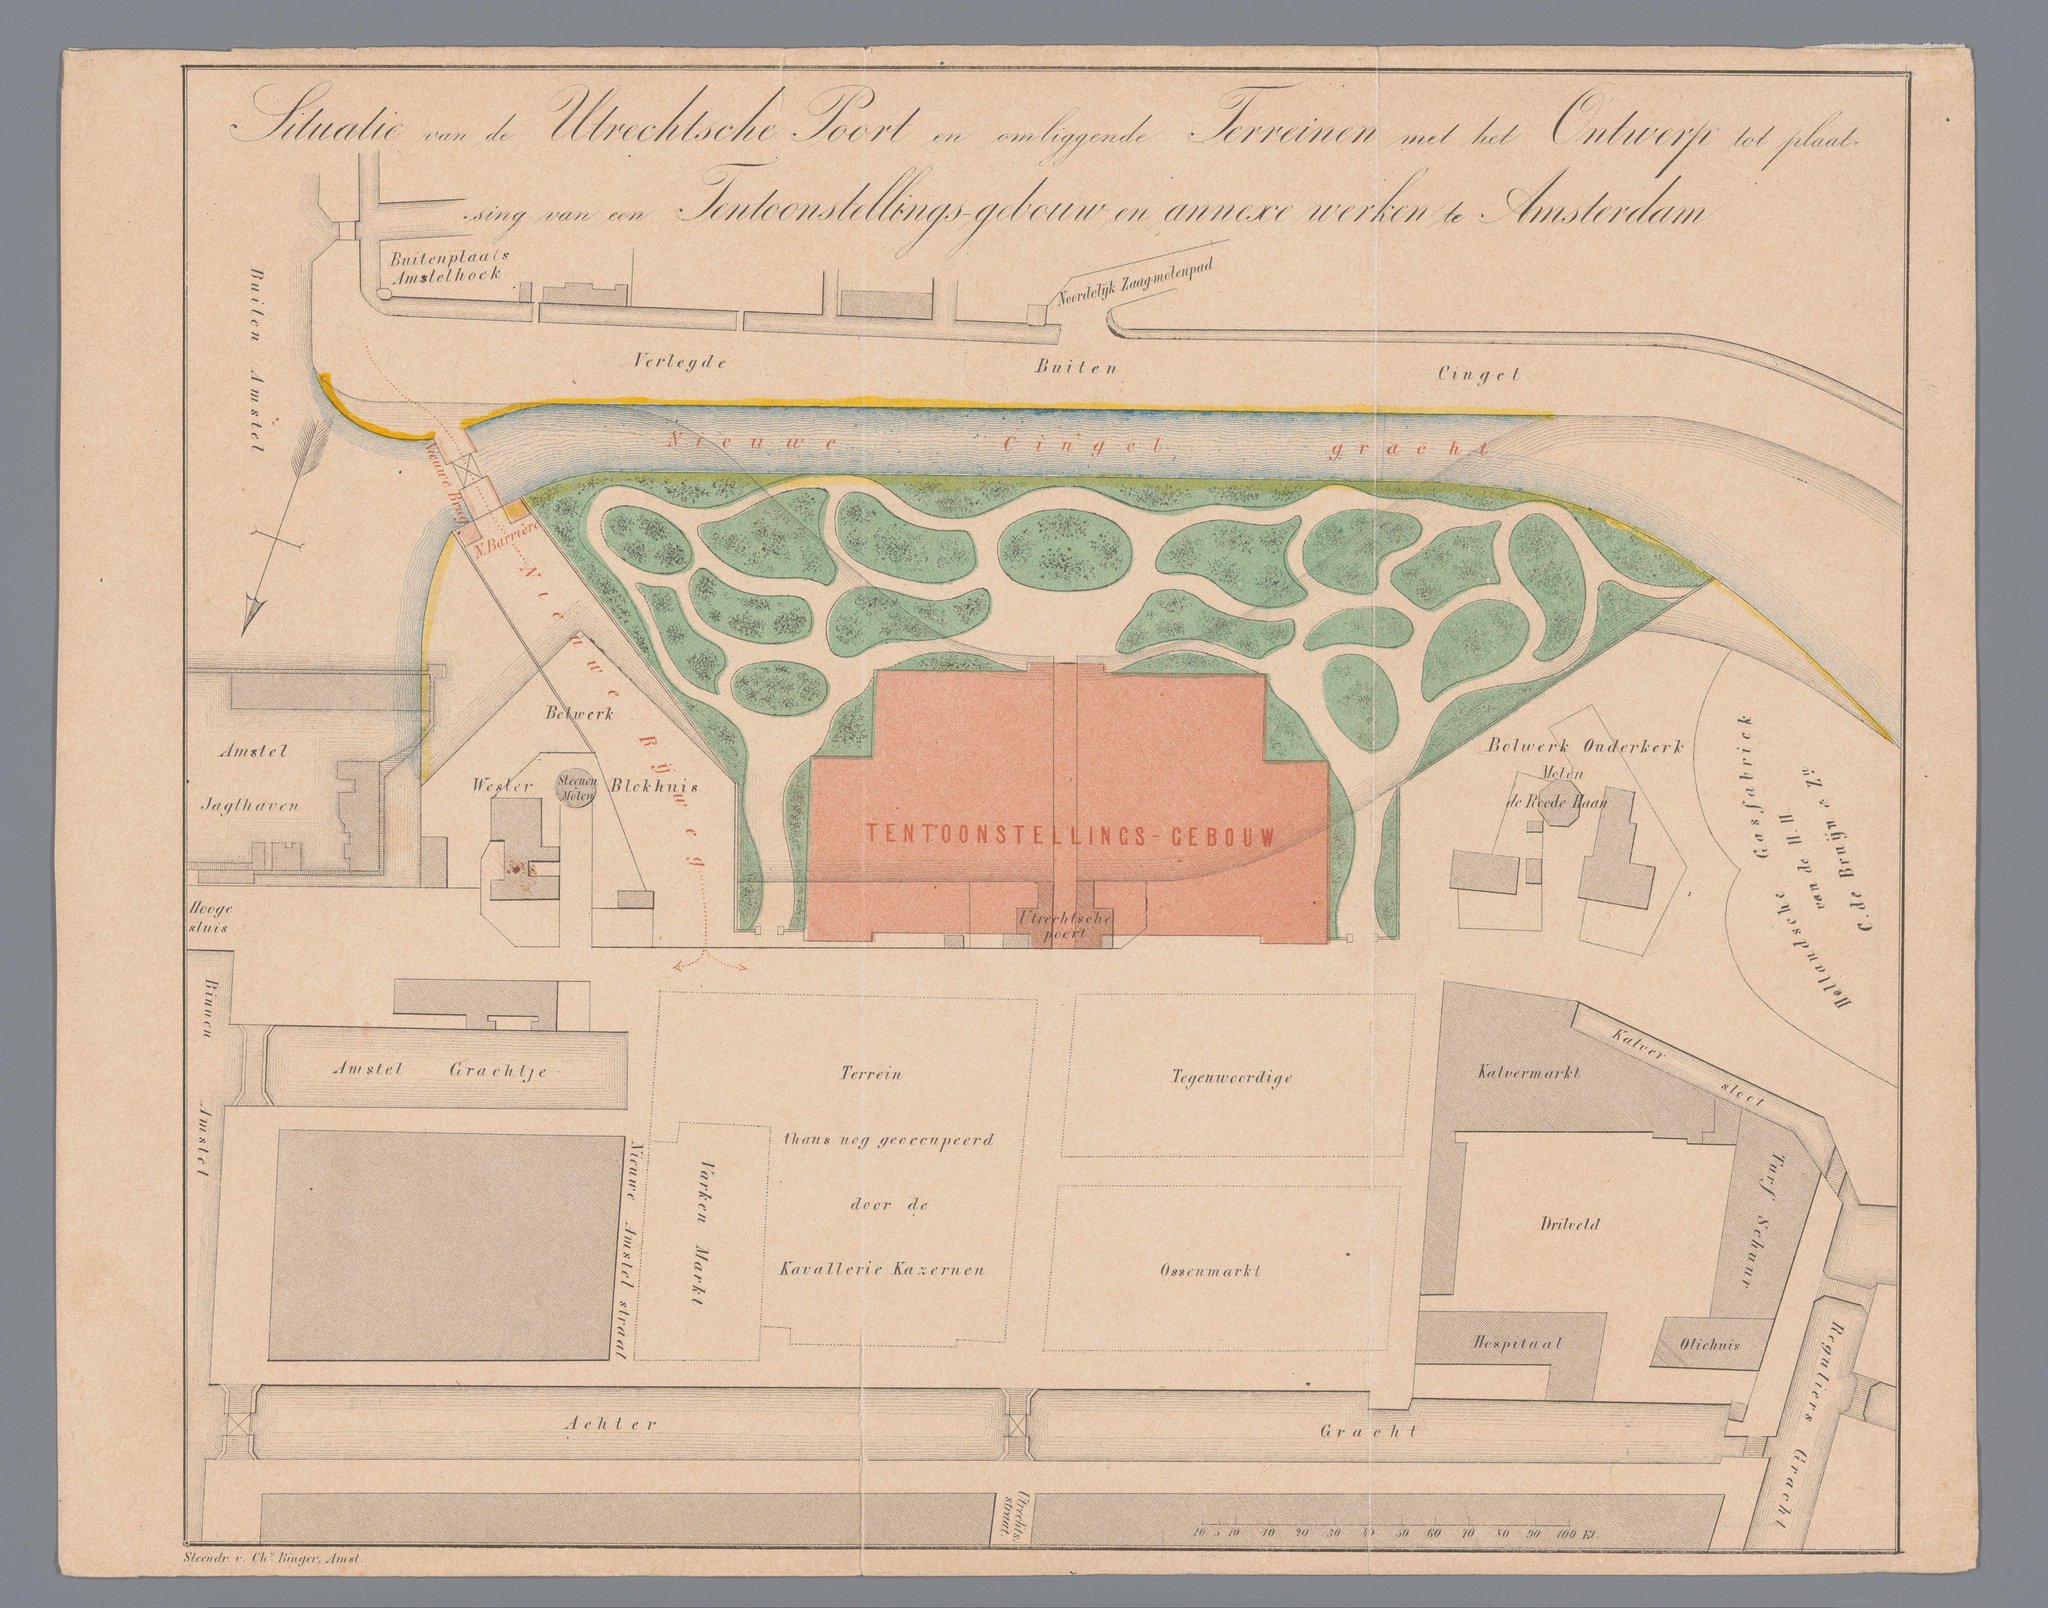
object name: area plan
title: Voorgesteld ontwerp voor het Paleis voor Volksvlijt op de plek van de Utrechtsepoort in Amsterdam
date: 1855-1865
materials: paper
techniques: lithograph, hand coloring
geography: amsterdam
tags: maps of cities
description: Mogelijk is dit één van de inzendingen in reactie op de prijsvraag voor het ontwerp van het Paleis voor Volksvlijt, volgens Wikipedia in 1856 uitgeschreven.